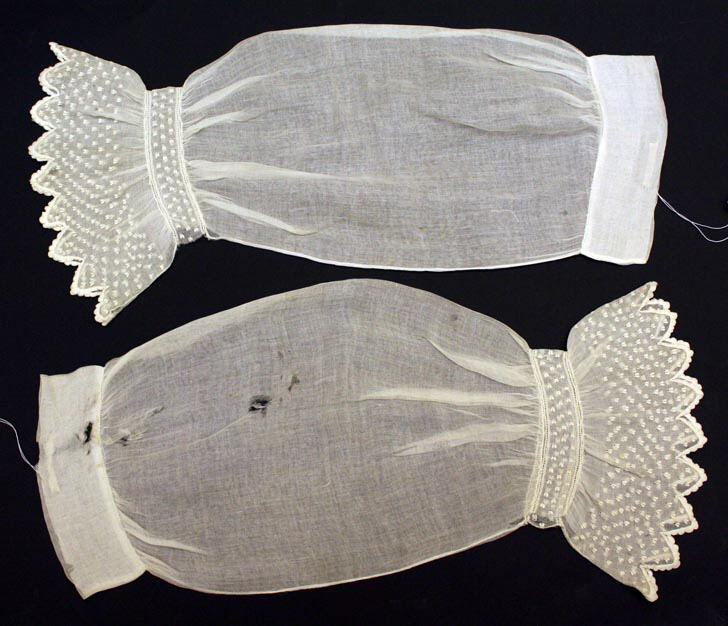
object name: undersleeves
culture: american or european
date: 1860-1869